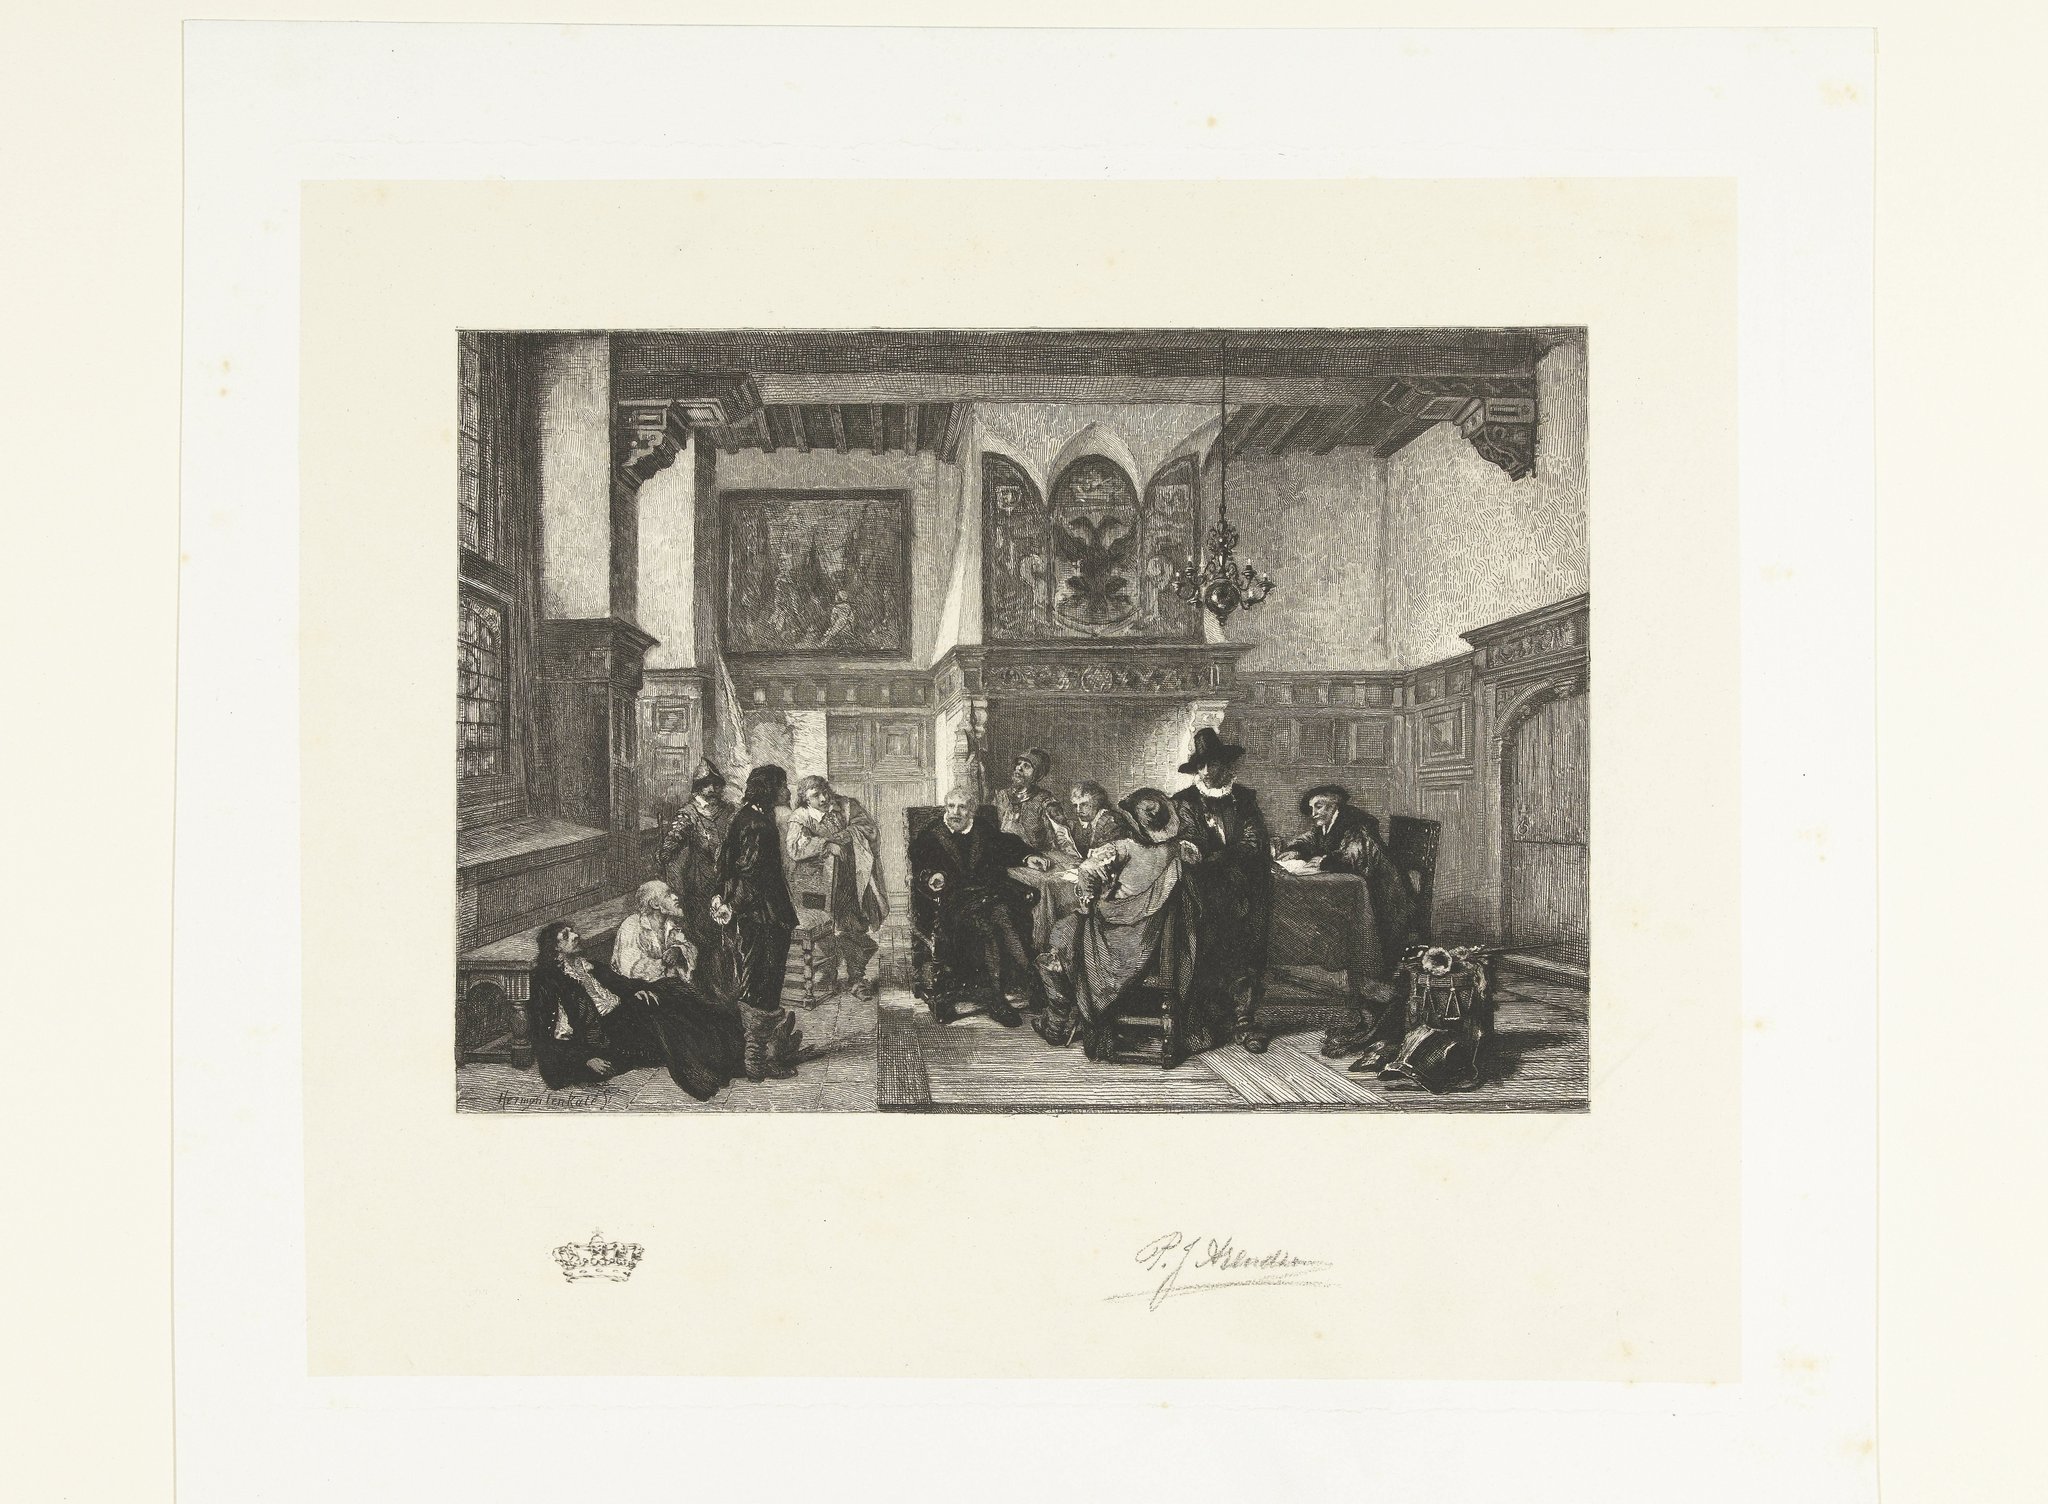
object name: print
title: Een krijgsraad in de zeventiende eeuw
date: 1867-1909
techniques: printmaking, etching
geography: netherlands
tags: interrogation of arrested person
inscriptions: collector's mark: Lugt 2228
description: Coll. de la Faille. naar het schilderij in Museum Boijmans Van Beuningen, Rotterdam, inv.nr. 1396